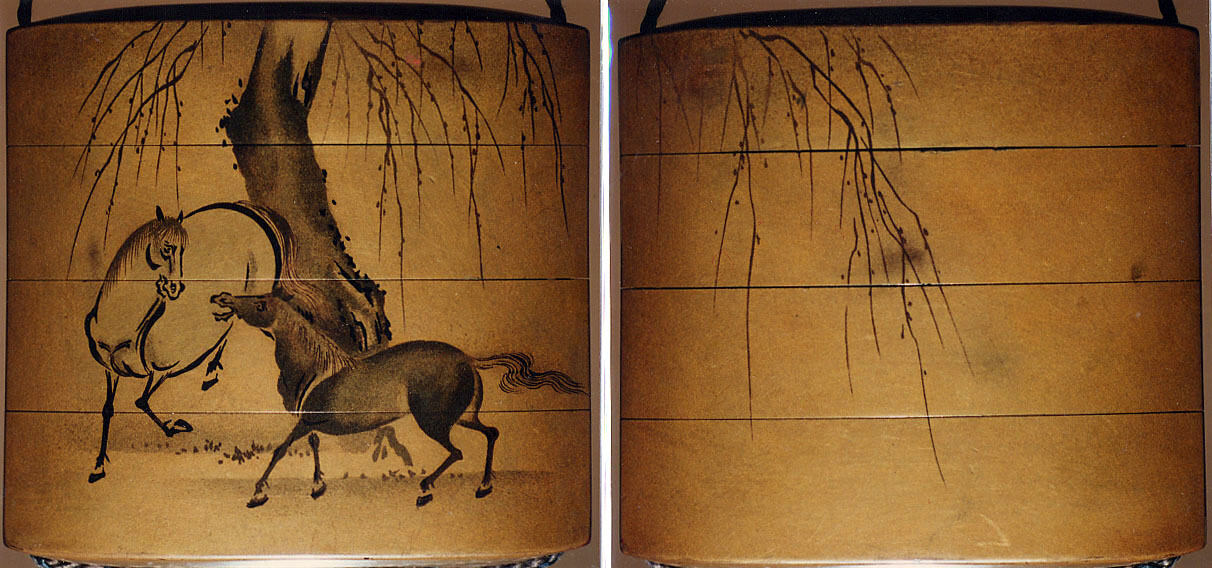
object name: inrō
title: Case (Inrō) with Design of Two Horses beneath Leafless Weeping Willow Tree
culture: japanese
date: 1801-1900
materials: lacquer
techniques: fundame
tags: horses,trees